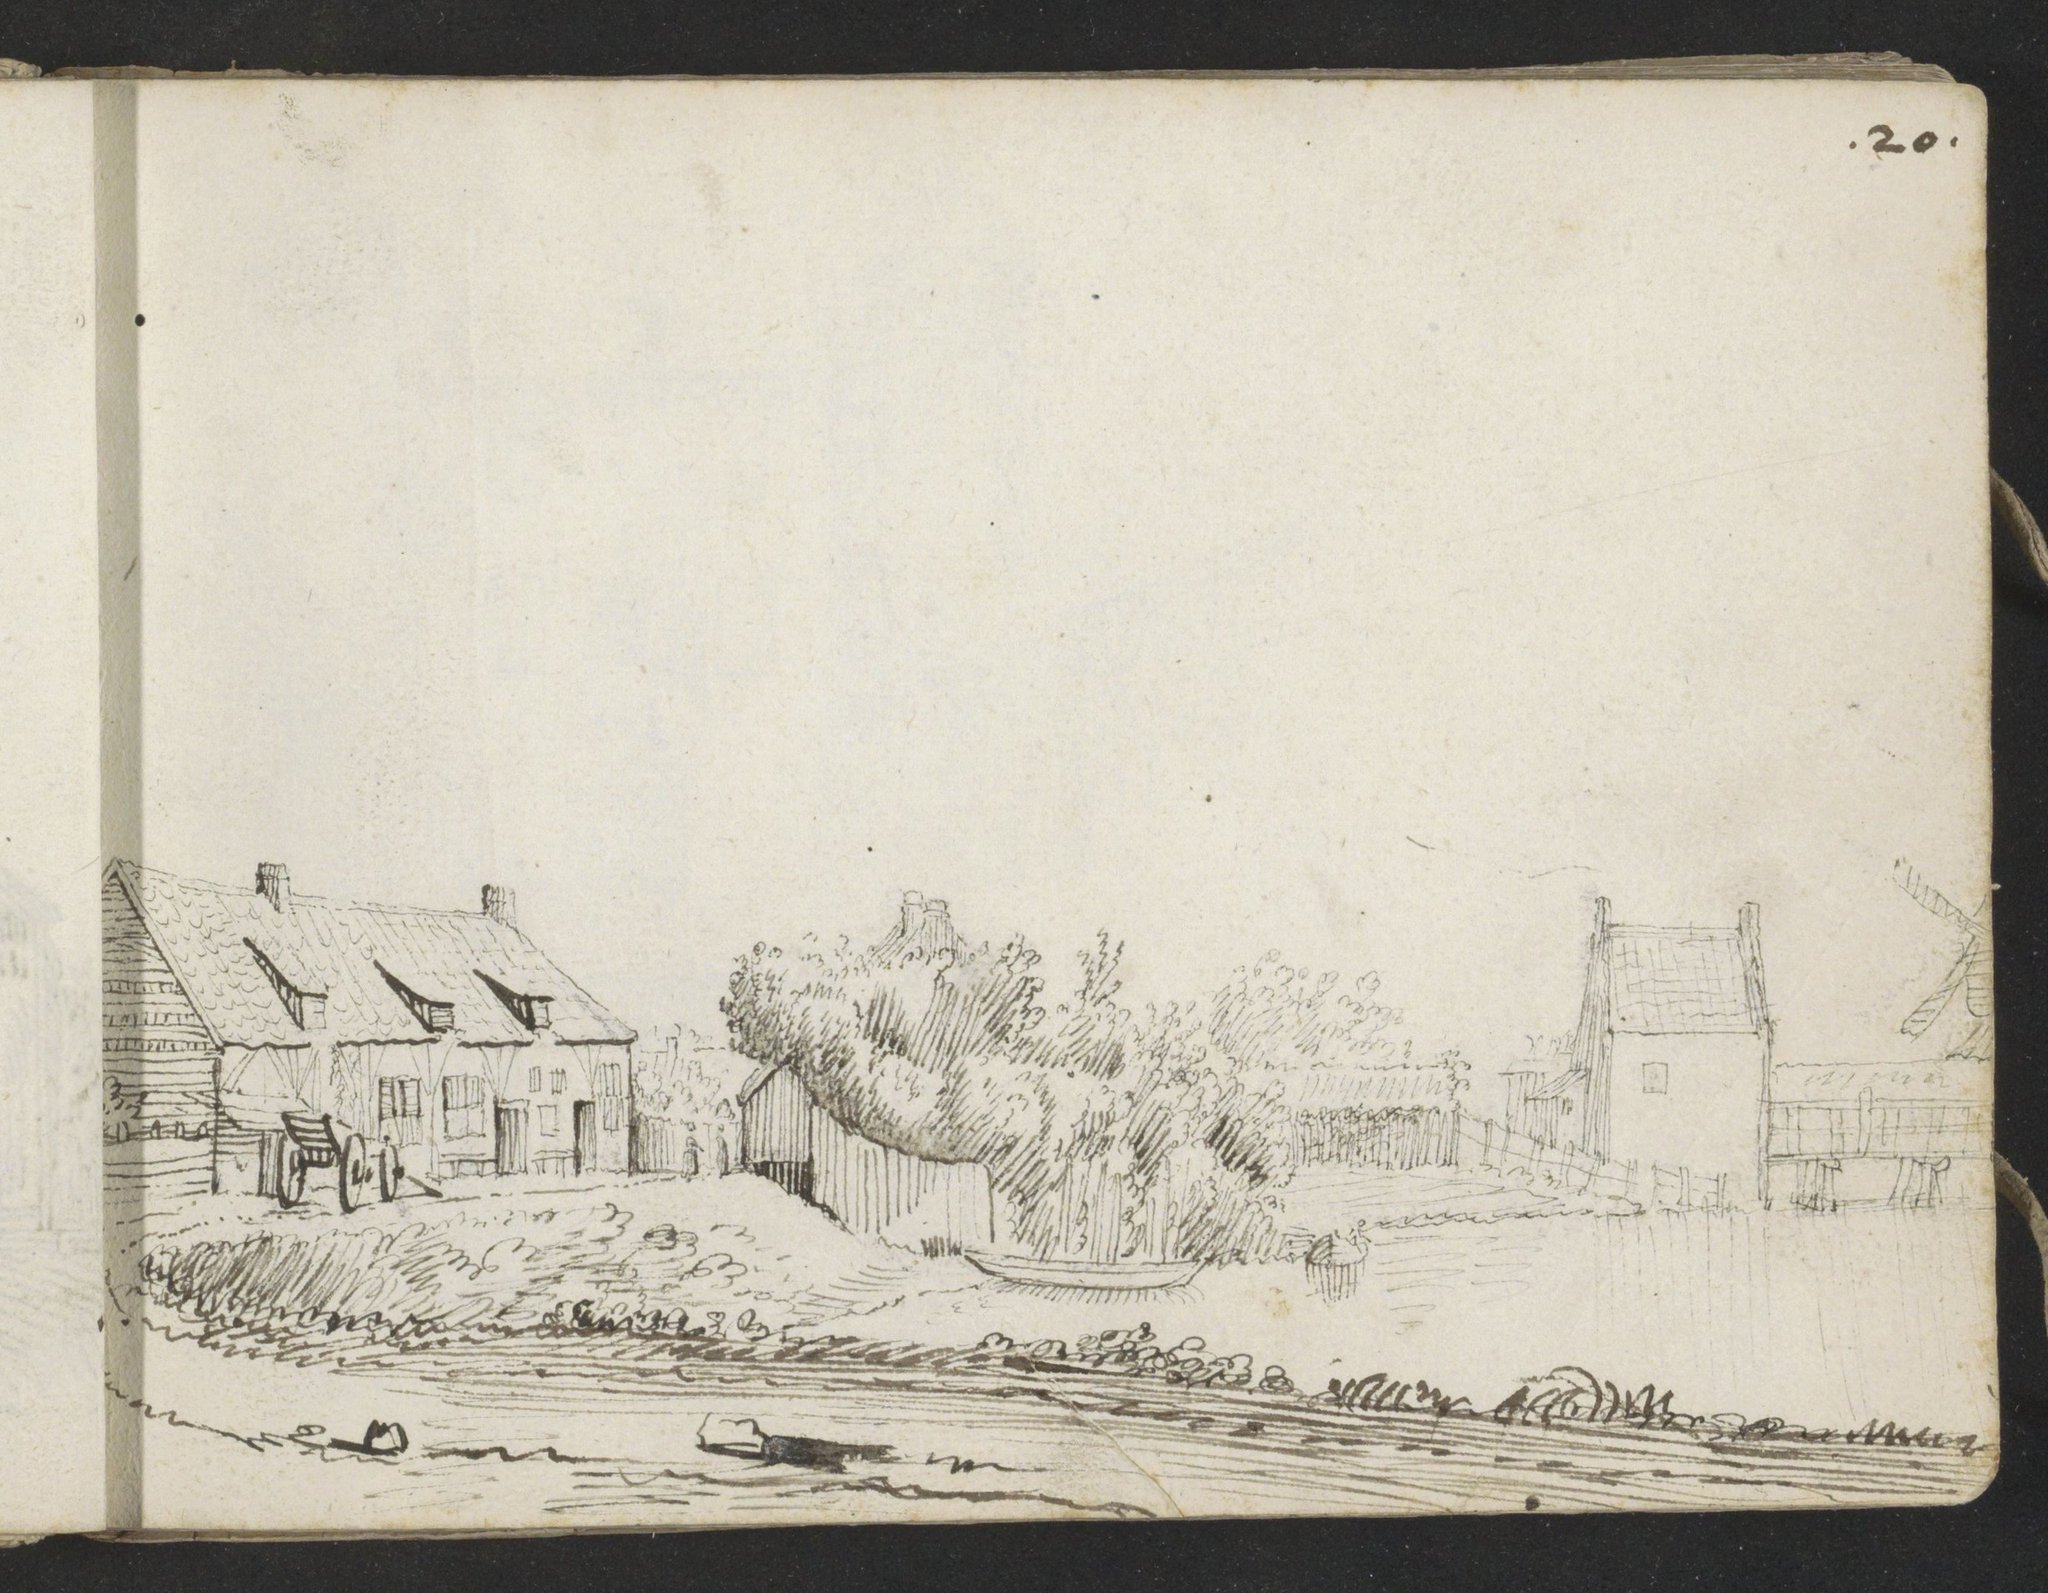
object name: sketchbook leaf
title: Huizen aan de singel buiten de Diezerbuitenpoort te Zwolle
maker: gerard ter borch (ii)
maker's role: draughtsman, painter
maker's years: 1617-1681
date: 1631-1633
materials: ink, paper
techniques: pen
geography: zwolle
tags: canals, waters (in city), the usual house or row of houses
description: Blad 20 recto uit een schetsboek met 55 bladen.